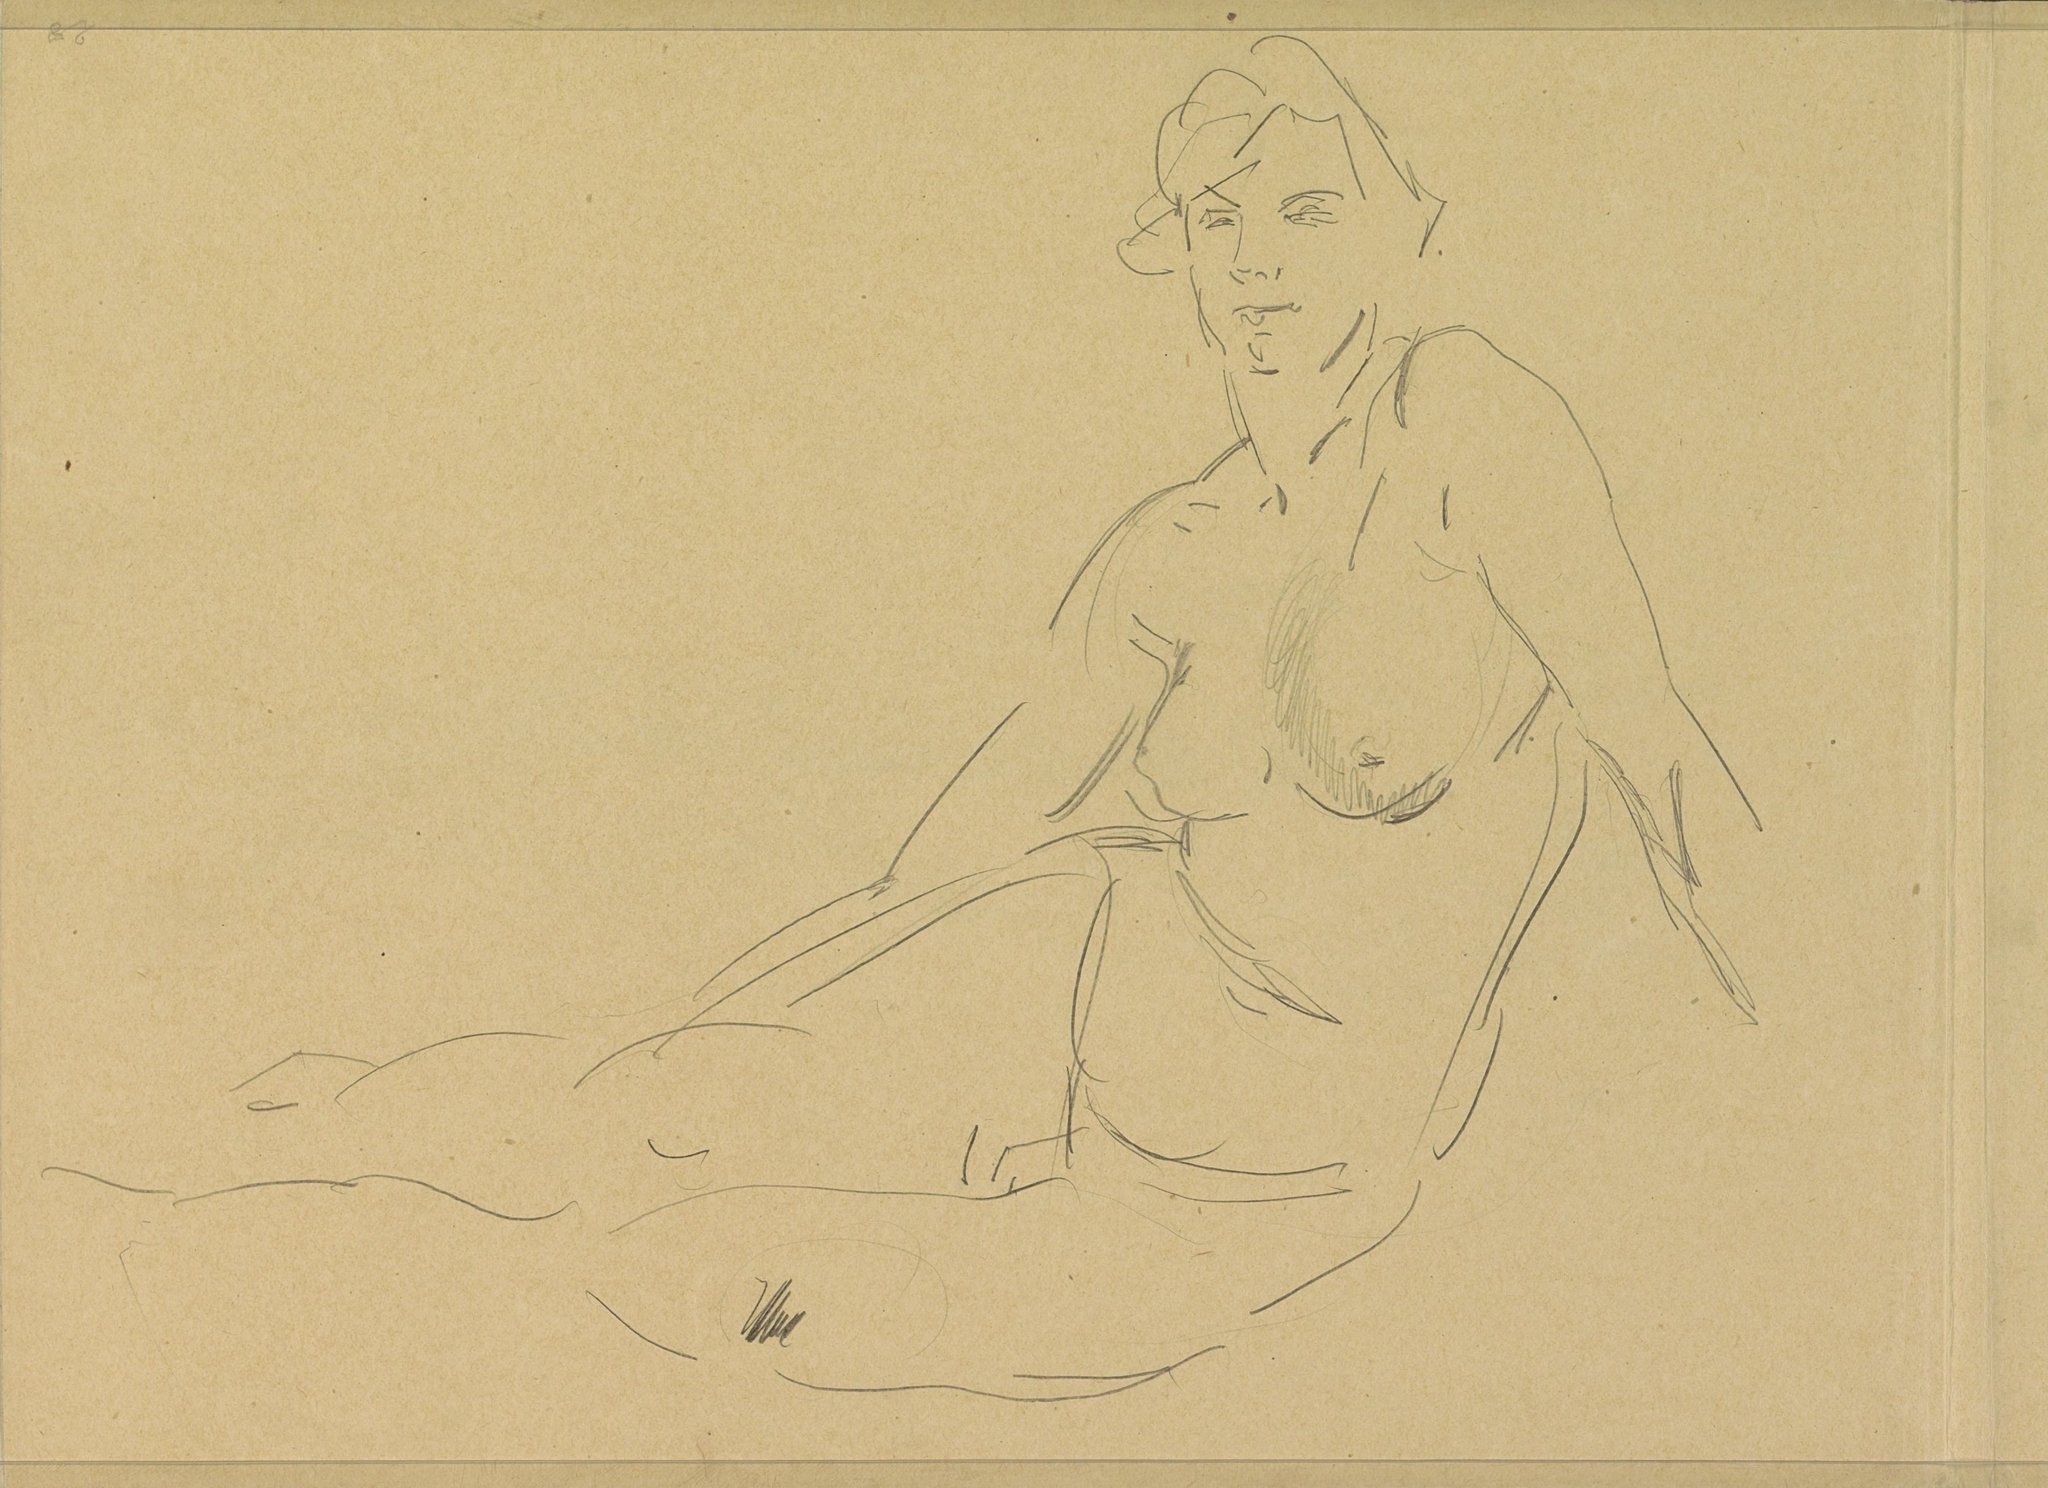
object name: sketchbook leaf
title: Seated Female Nude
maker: isaac israels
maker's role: draughtsman, painter, print maker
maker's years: 1865-1934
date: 1875-1934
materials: paper, pencil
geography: the hague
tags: sitting figure - aa - female human figure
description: Ze leunt op haar linkerarm. Blad 27 verso uit schetsboek IV met 27 bladen.